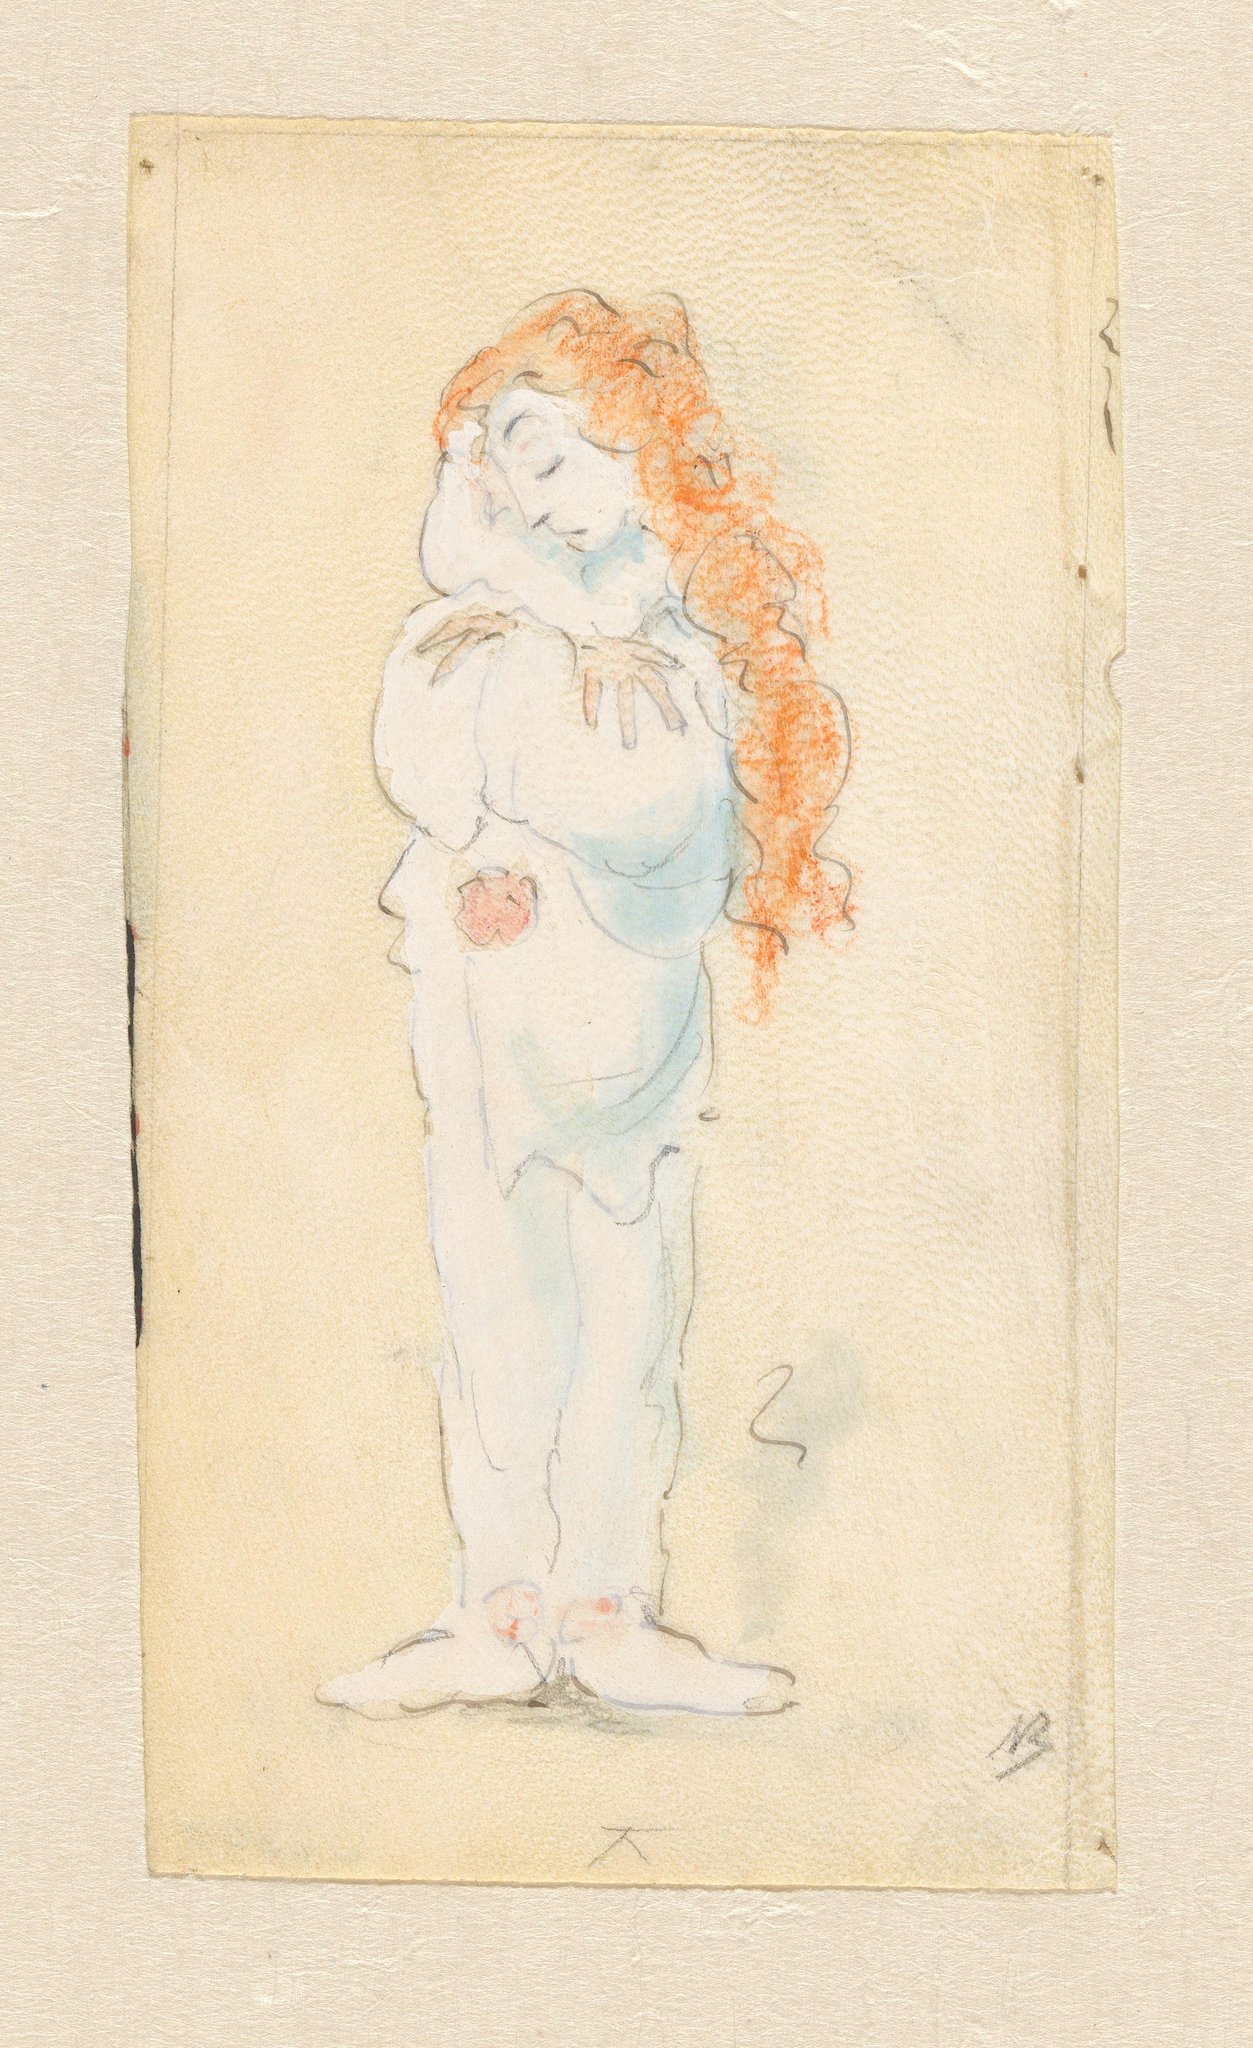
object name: drawing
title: Pierrot met lange rode haren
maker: nelly bodenheim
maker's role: designer, draughtsman, print maker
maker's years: 1874-1951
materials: paint, ink, parchment, pencil, watercolor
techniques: brush, pen